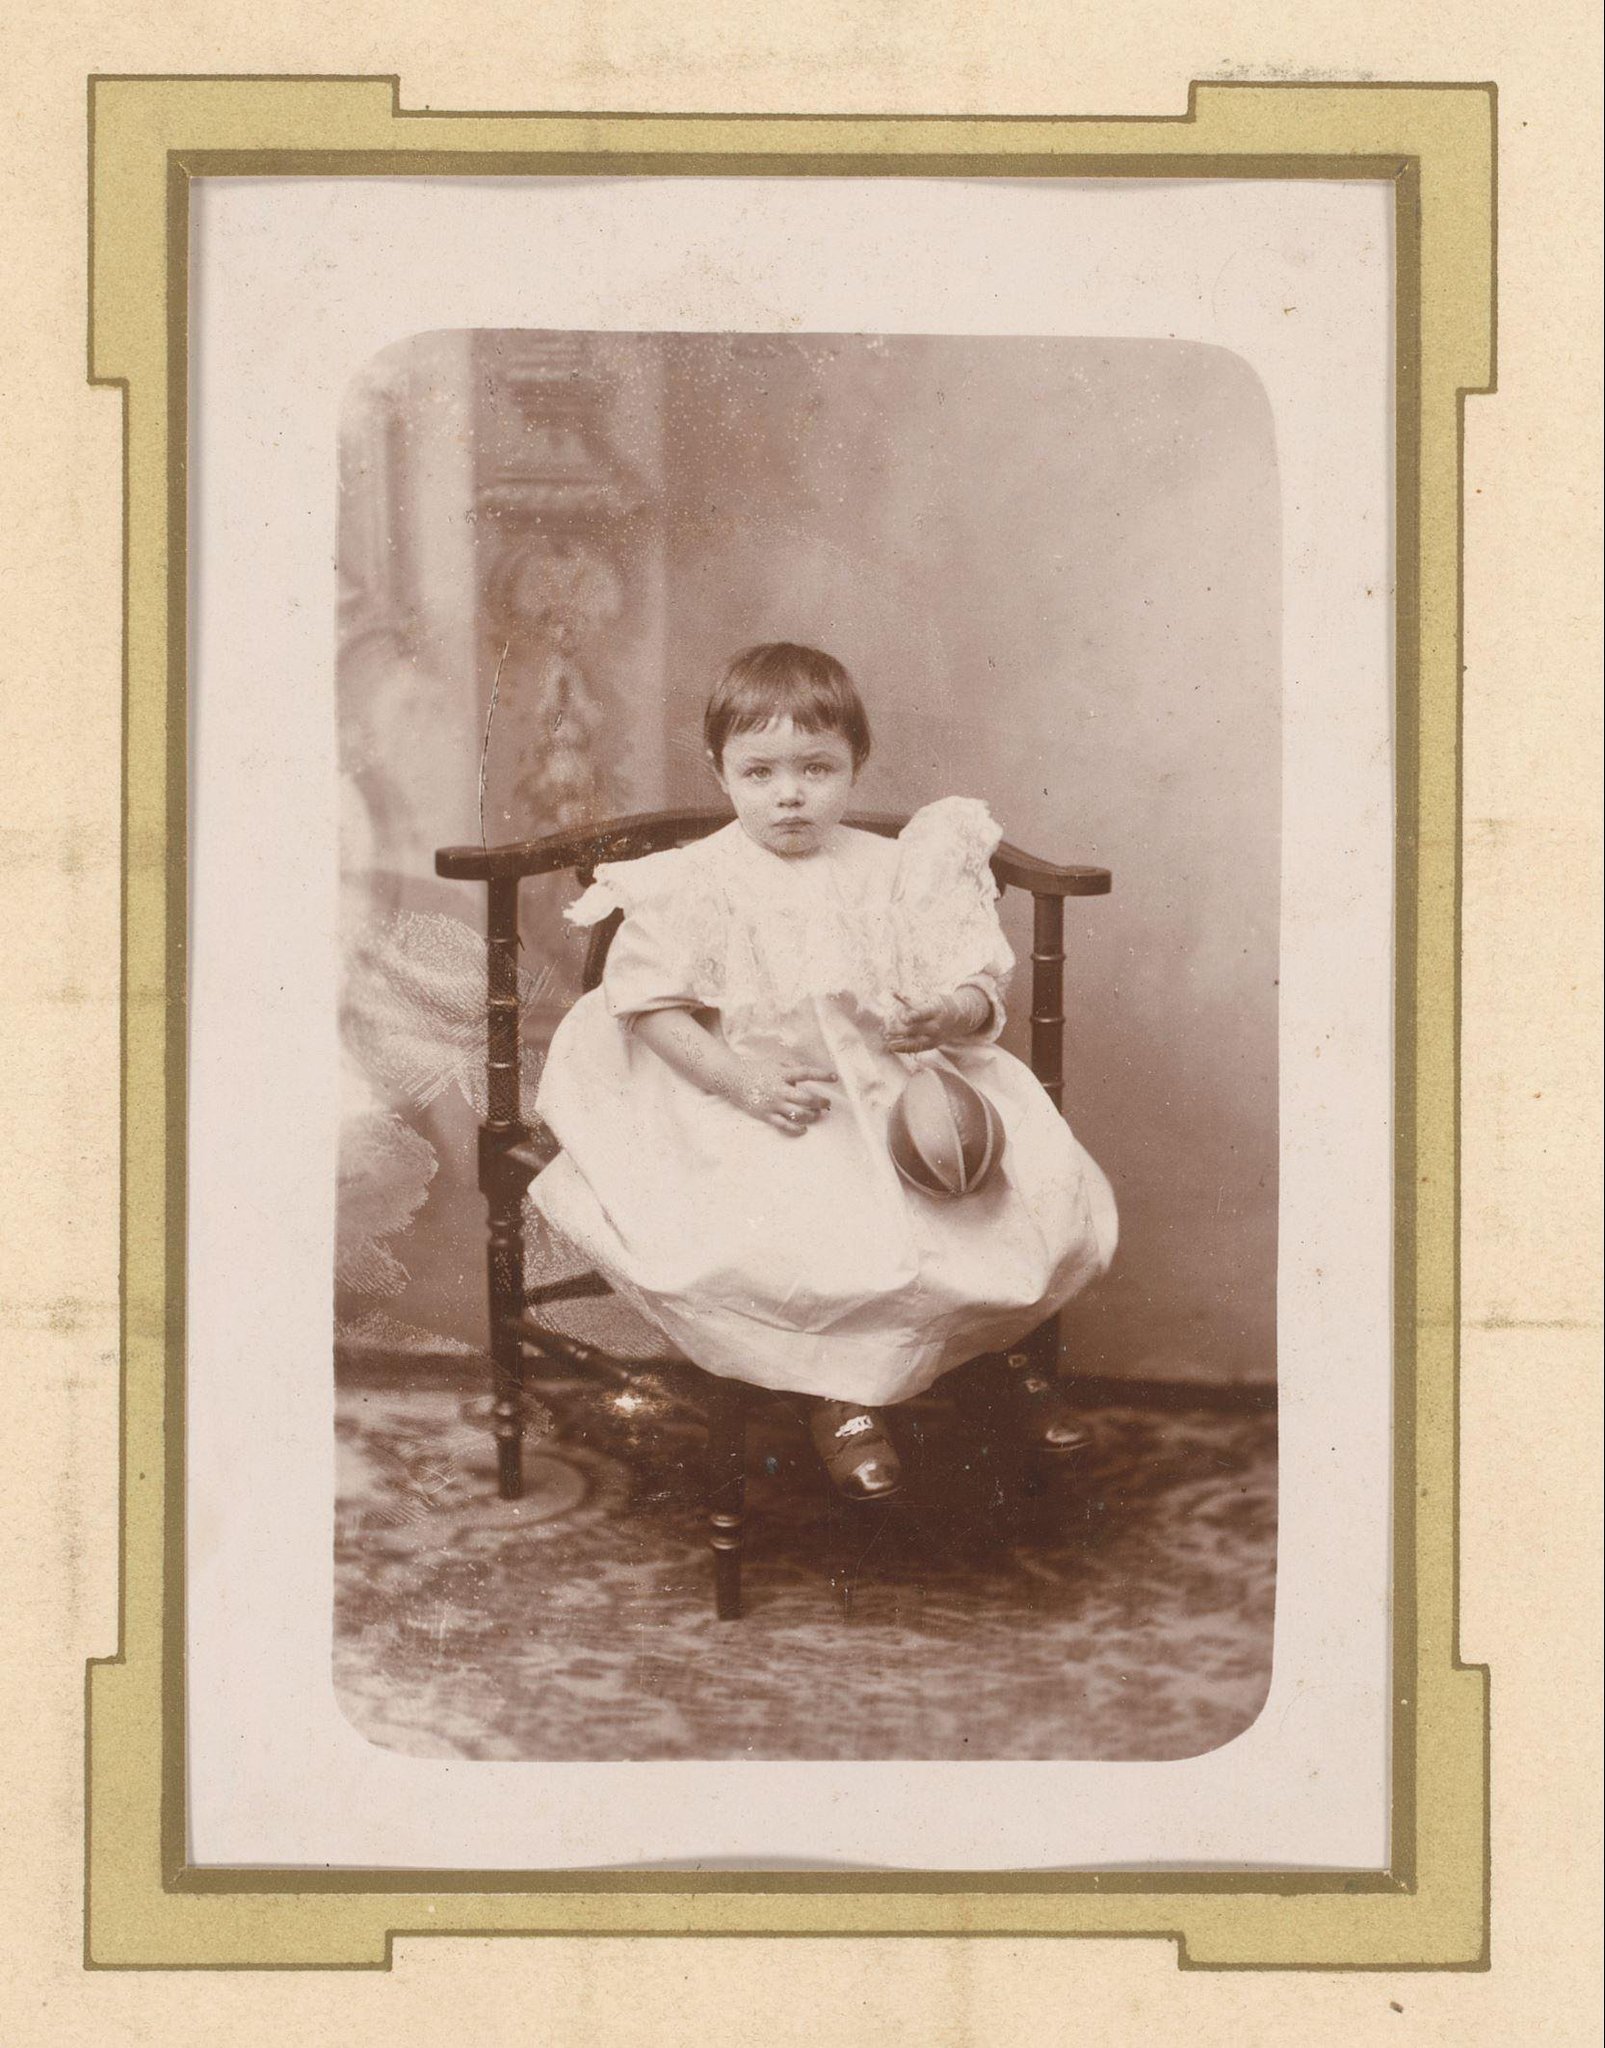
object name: cabinet photograph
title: Portret van Raymonde van Hoecke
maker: georges verger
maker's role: fotograaf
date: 1897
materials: cardboard, photographic support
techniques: collodion silver print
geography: lyon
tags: paris, girl (child between toddler and youth)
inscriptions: inscription: ‘Photographie/ Georges Verger/ 1, Cours Gambella et 2, Place Raspail/ Lyon’